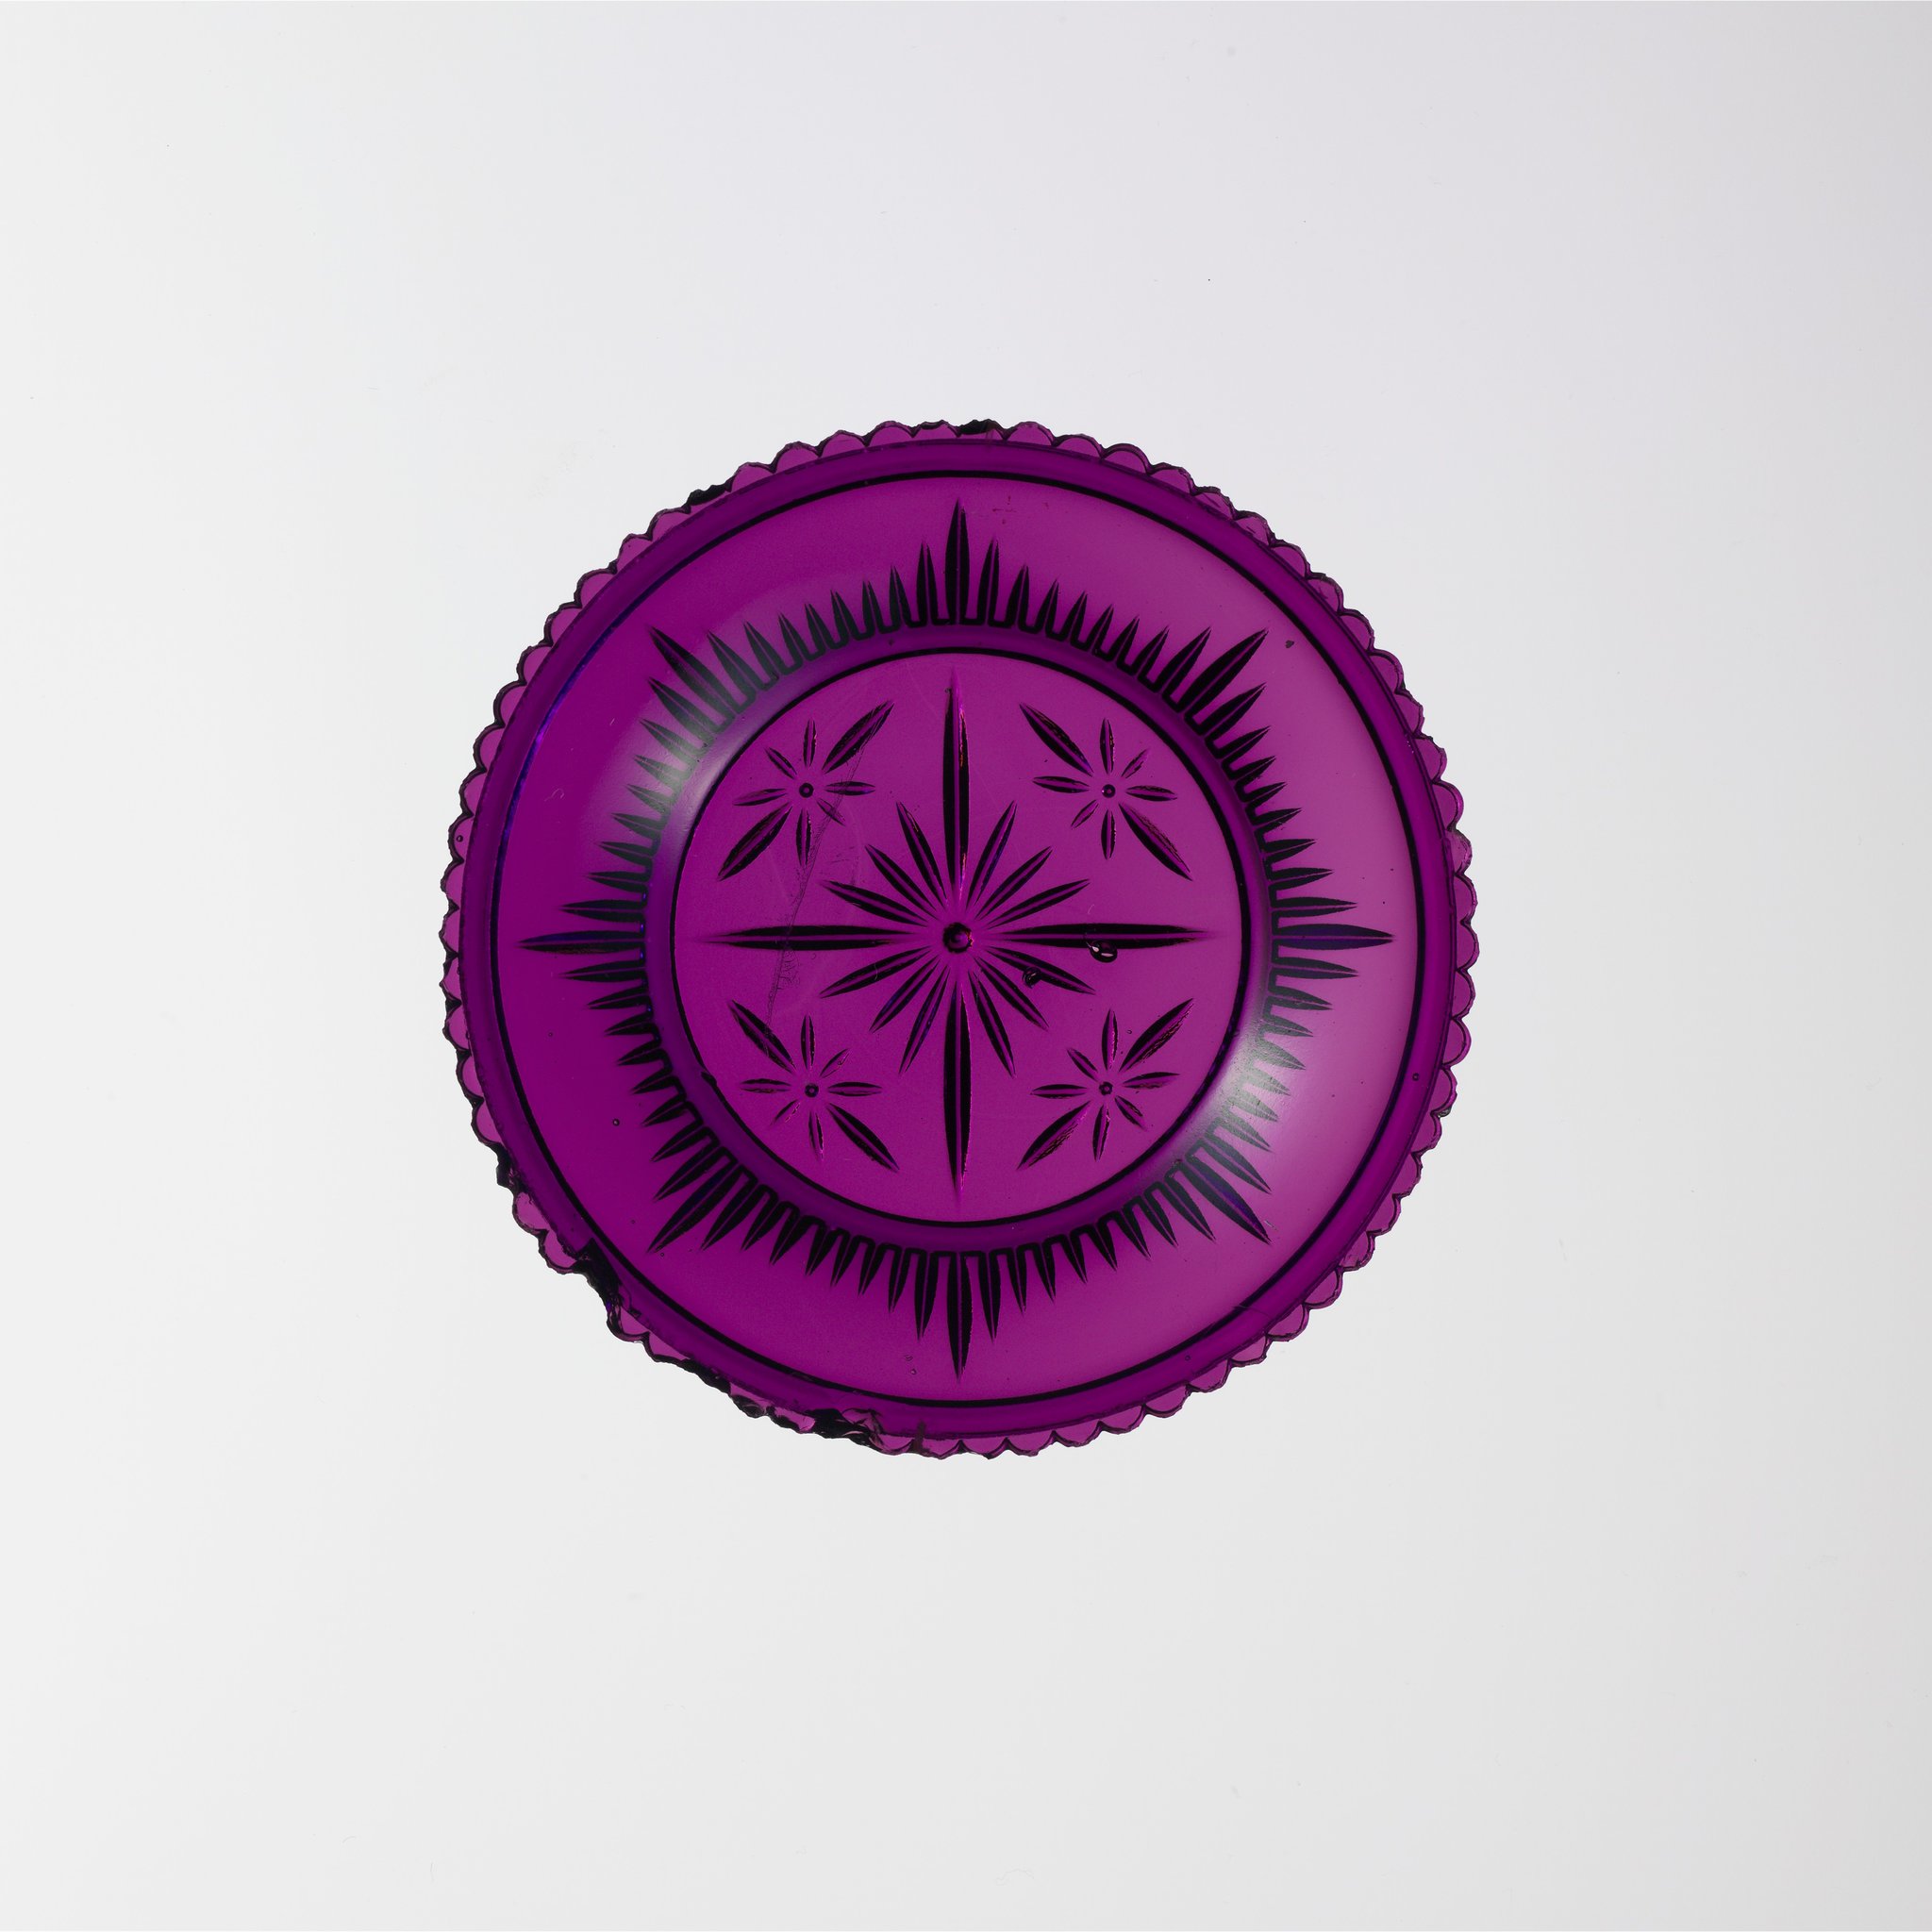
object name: cup plate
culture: american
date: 1825-1860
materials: glass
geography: united states